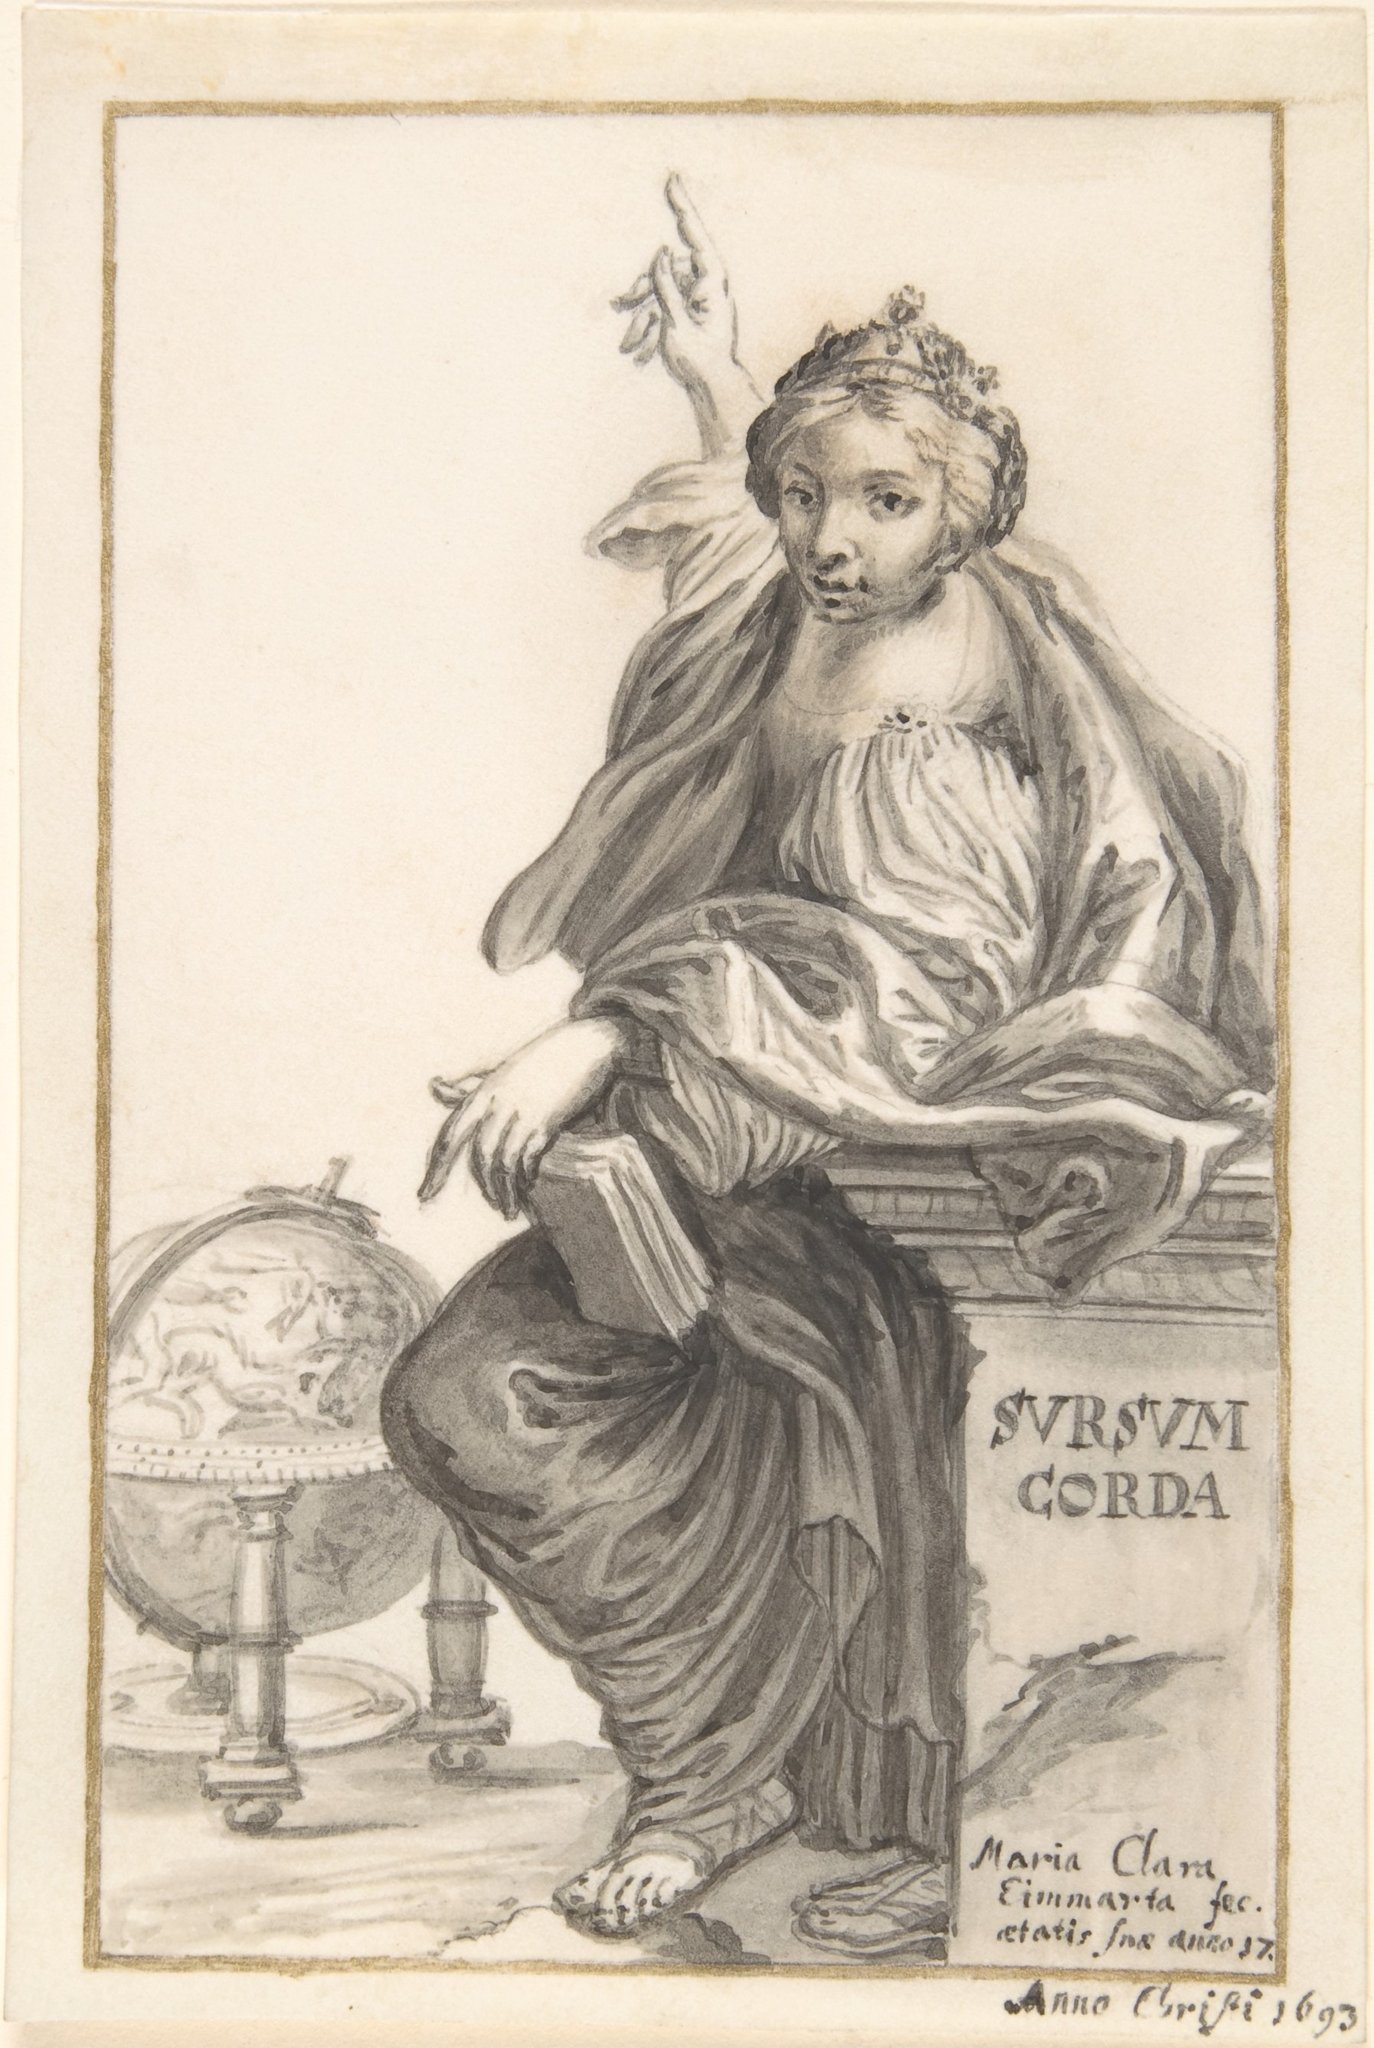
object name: drawing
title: Saint Margaret Ponting to Heaven, with a Globe Next to Her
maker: maria clara eimmart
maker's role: artist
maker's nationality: german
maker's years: 1676-1706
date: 1693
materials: gold, graphite, ink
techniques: brush, pen, wash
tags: women,saints,globes